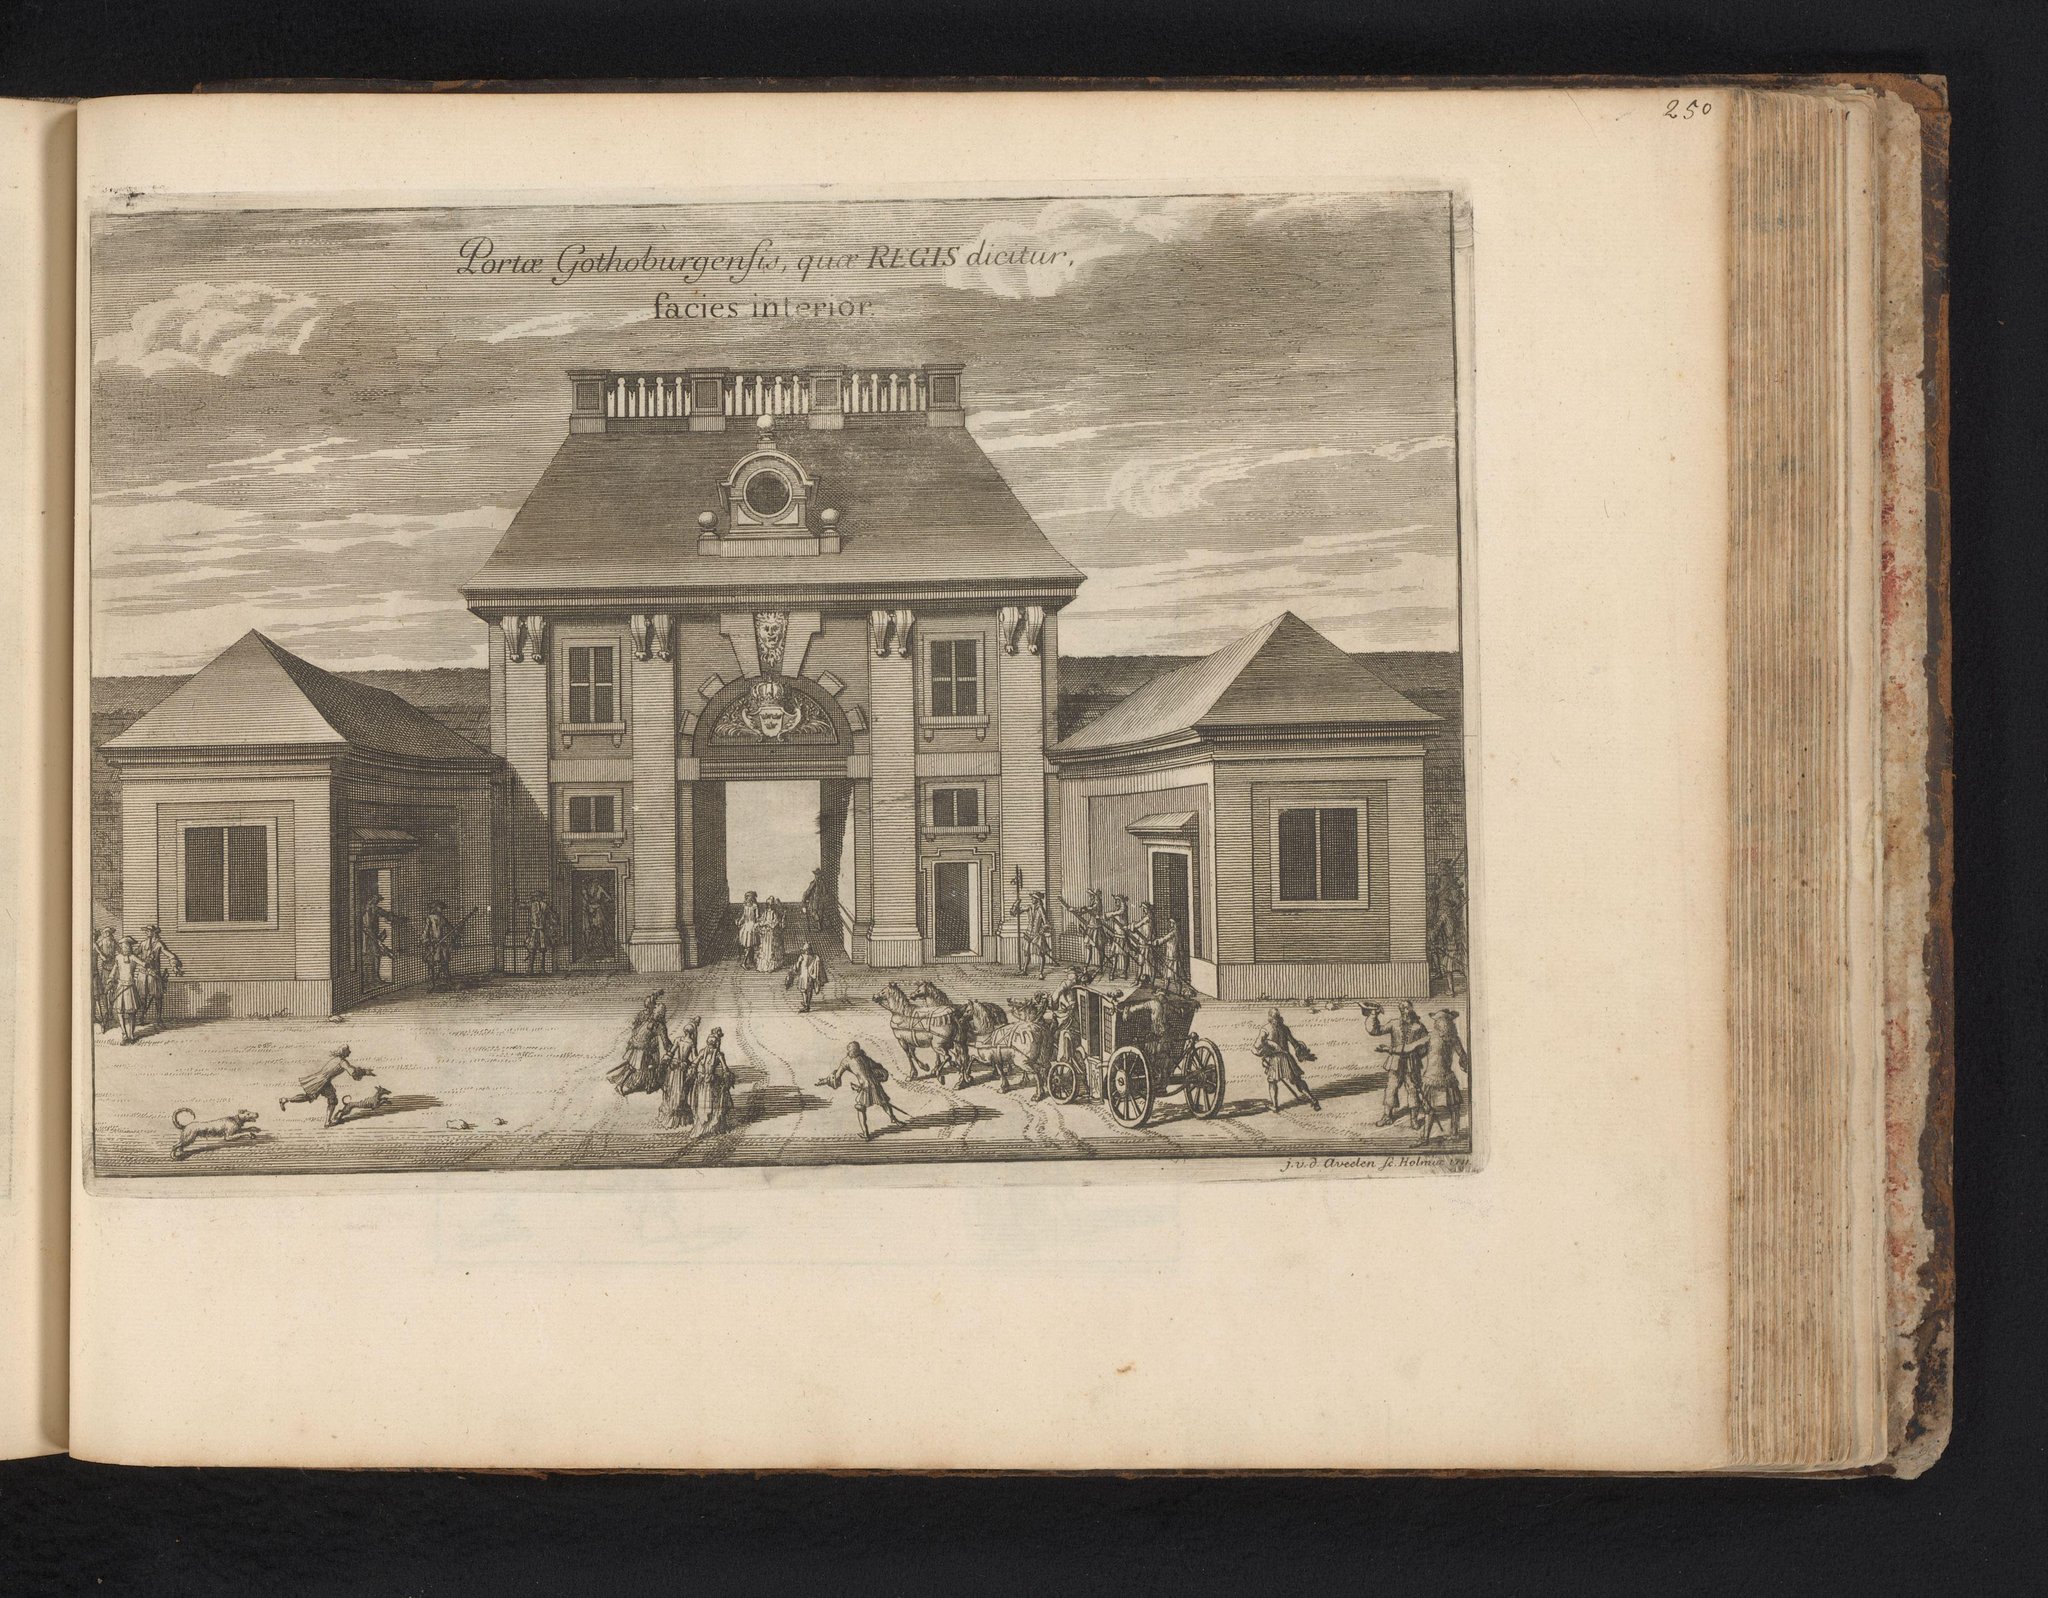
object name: print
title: Portae Gothoburgensis, quae Regis dicitur, facies interior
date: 1711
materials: paper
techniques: etching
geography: stockholm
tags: city-gate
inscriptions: date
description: Kungliga Biblioteket, 'Suecia': http://www.kb.se/samlingarna/Kartor-bilder/Suecia-antiqua/ (geraadpleegd november 2016).